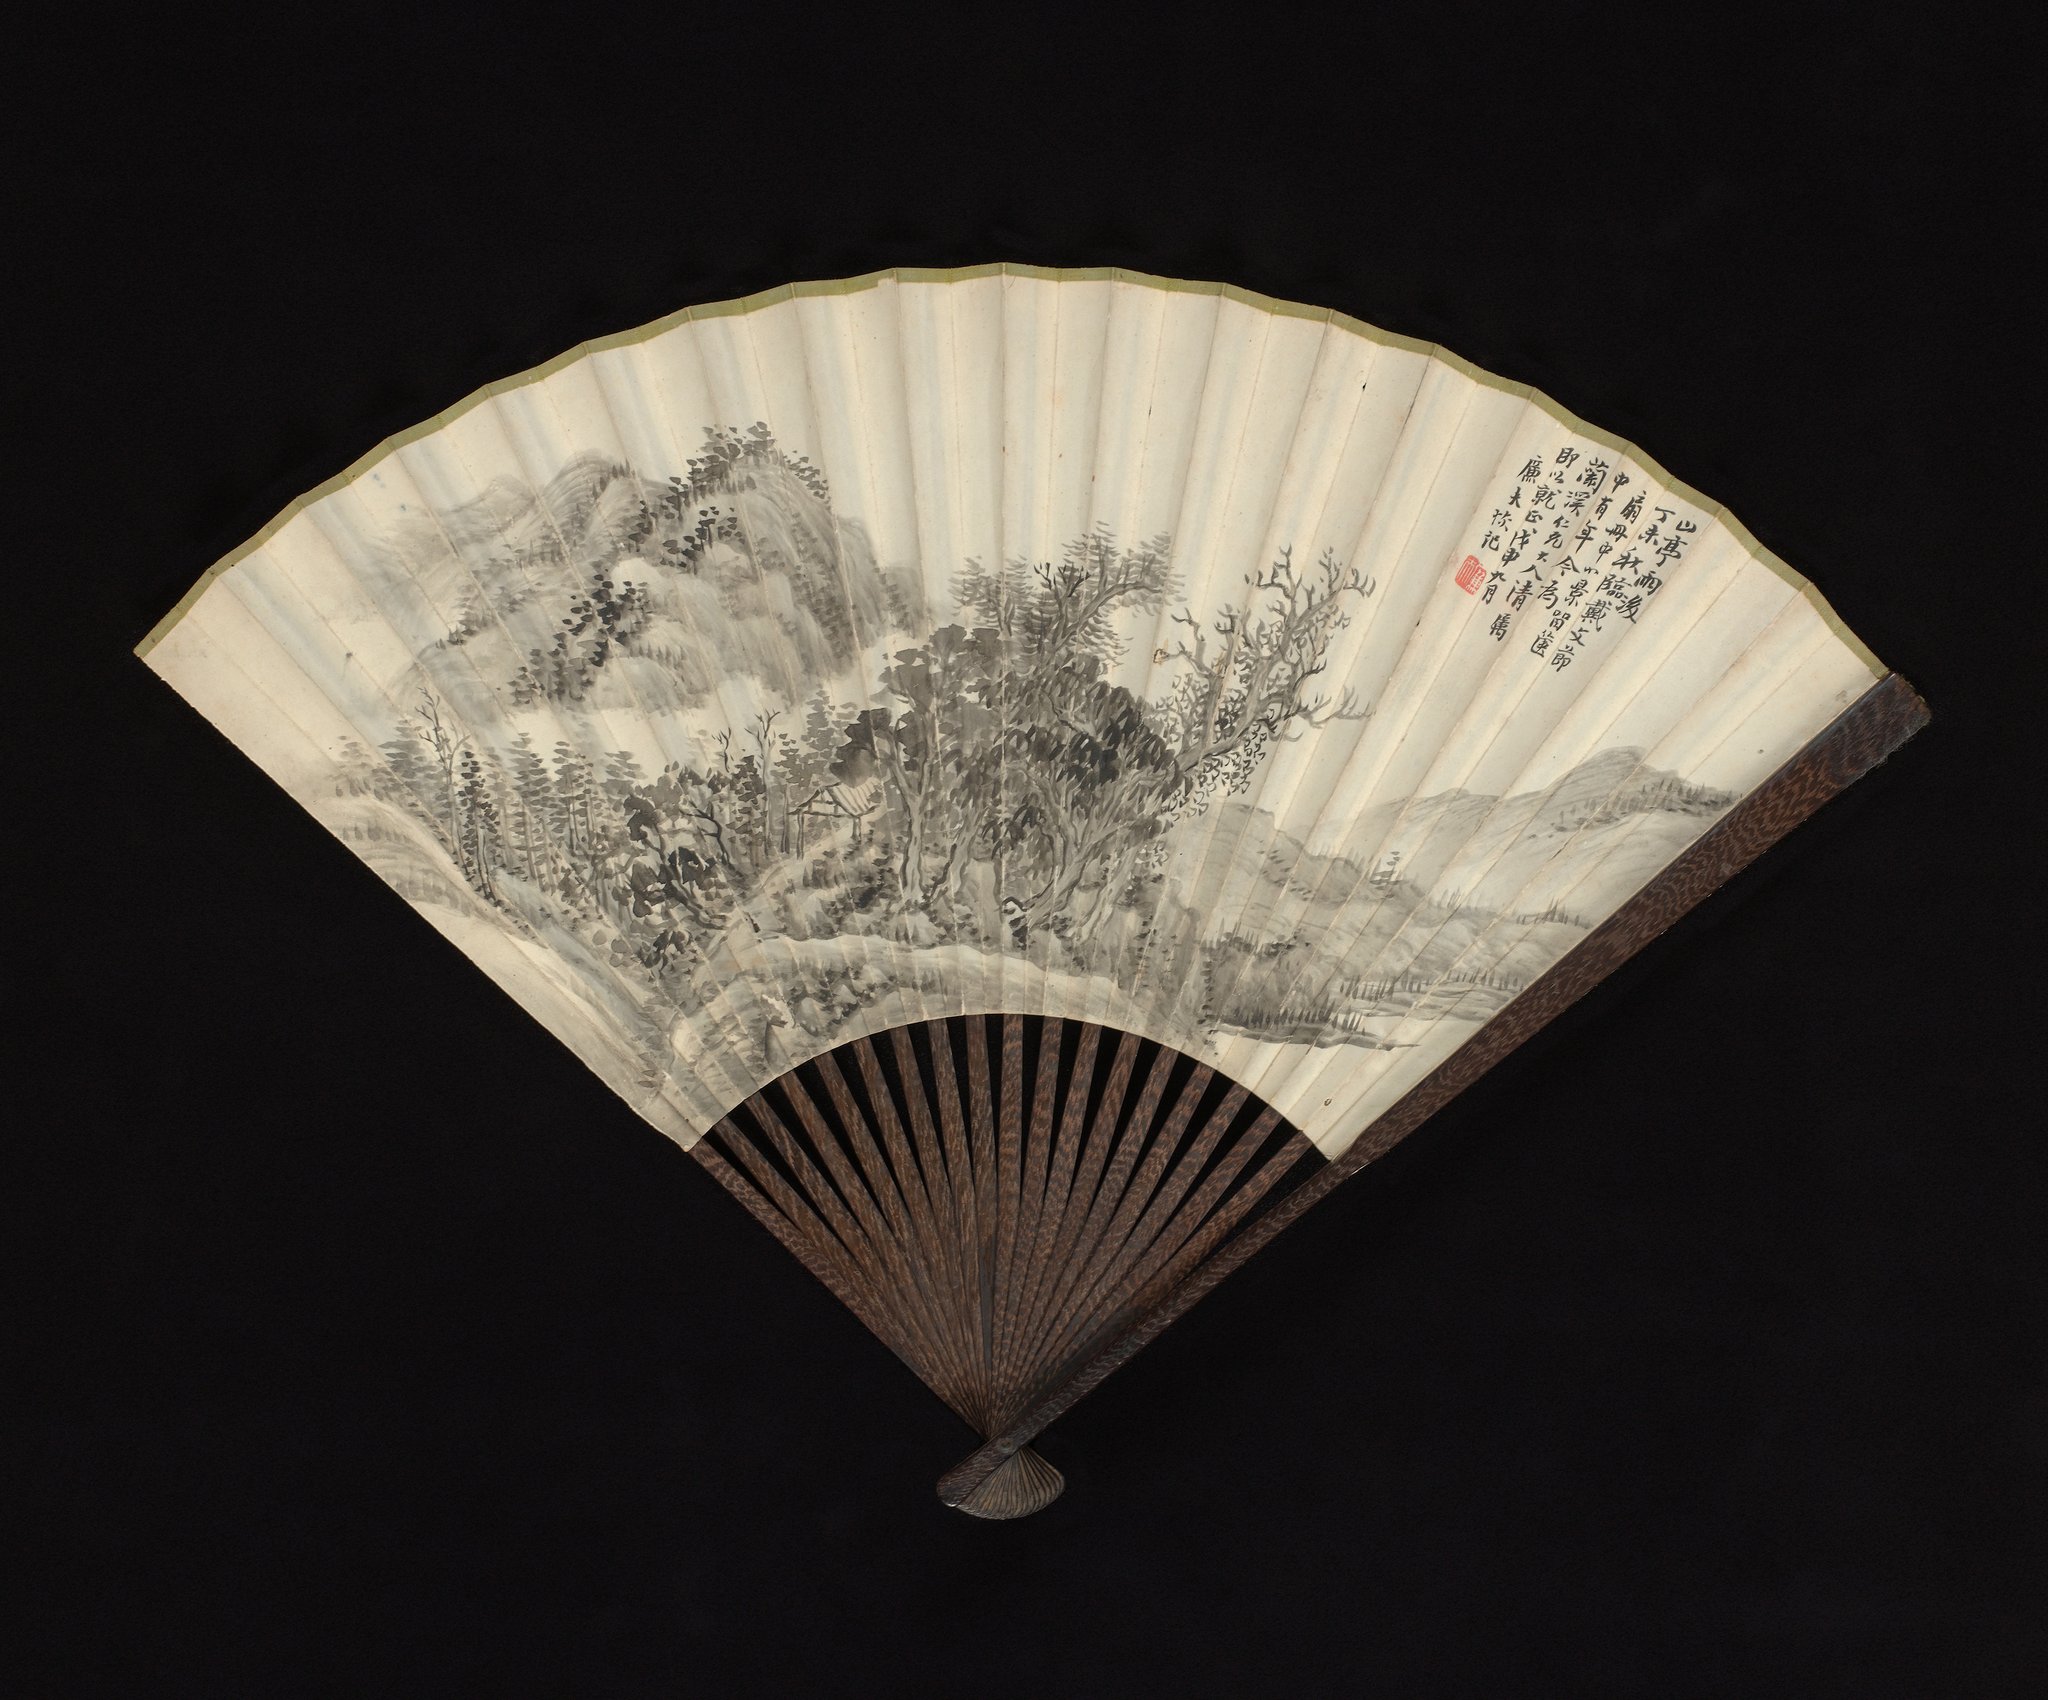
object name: folding fan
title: Mountain Pavillion after Rain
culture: chinese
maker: lu hui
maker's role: artist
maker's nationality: chinese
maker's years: 1851-1920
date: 1898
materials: ink, paper